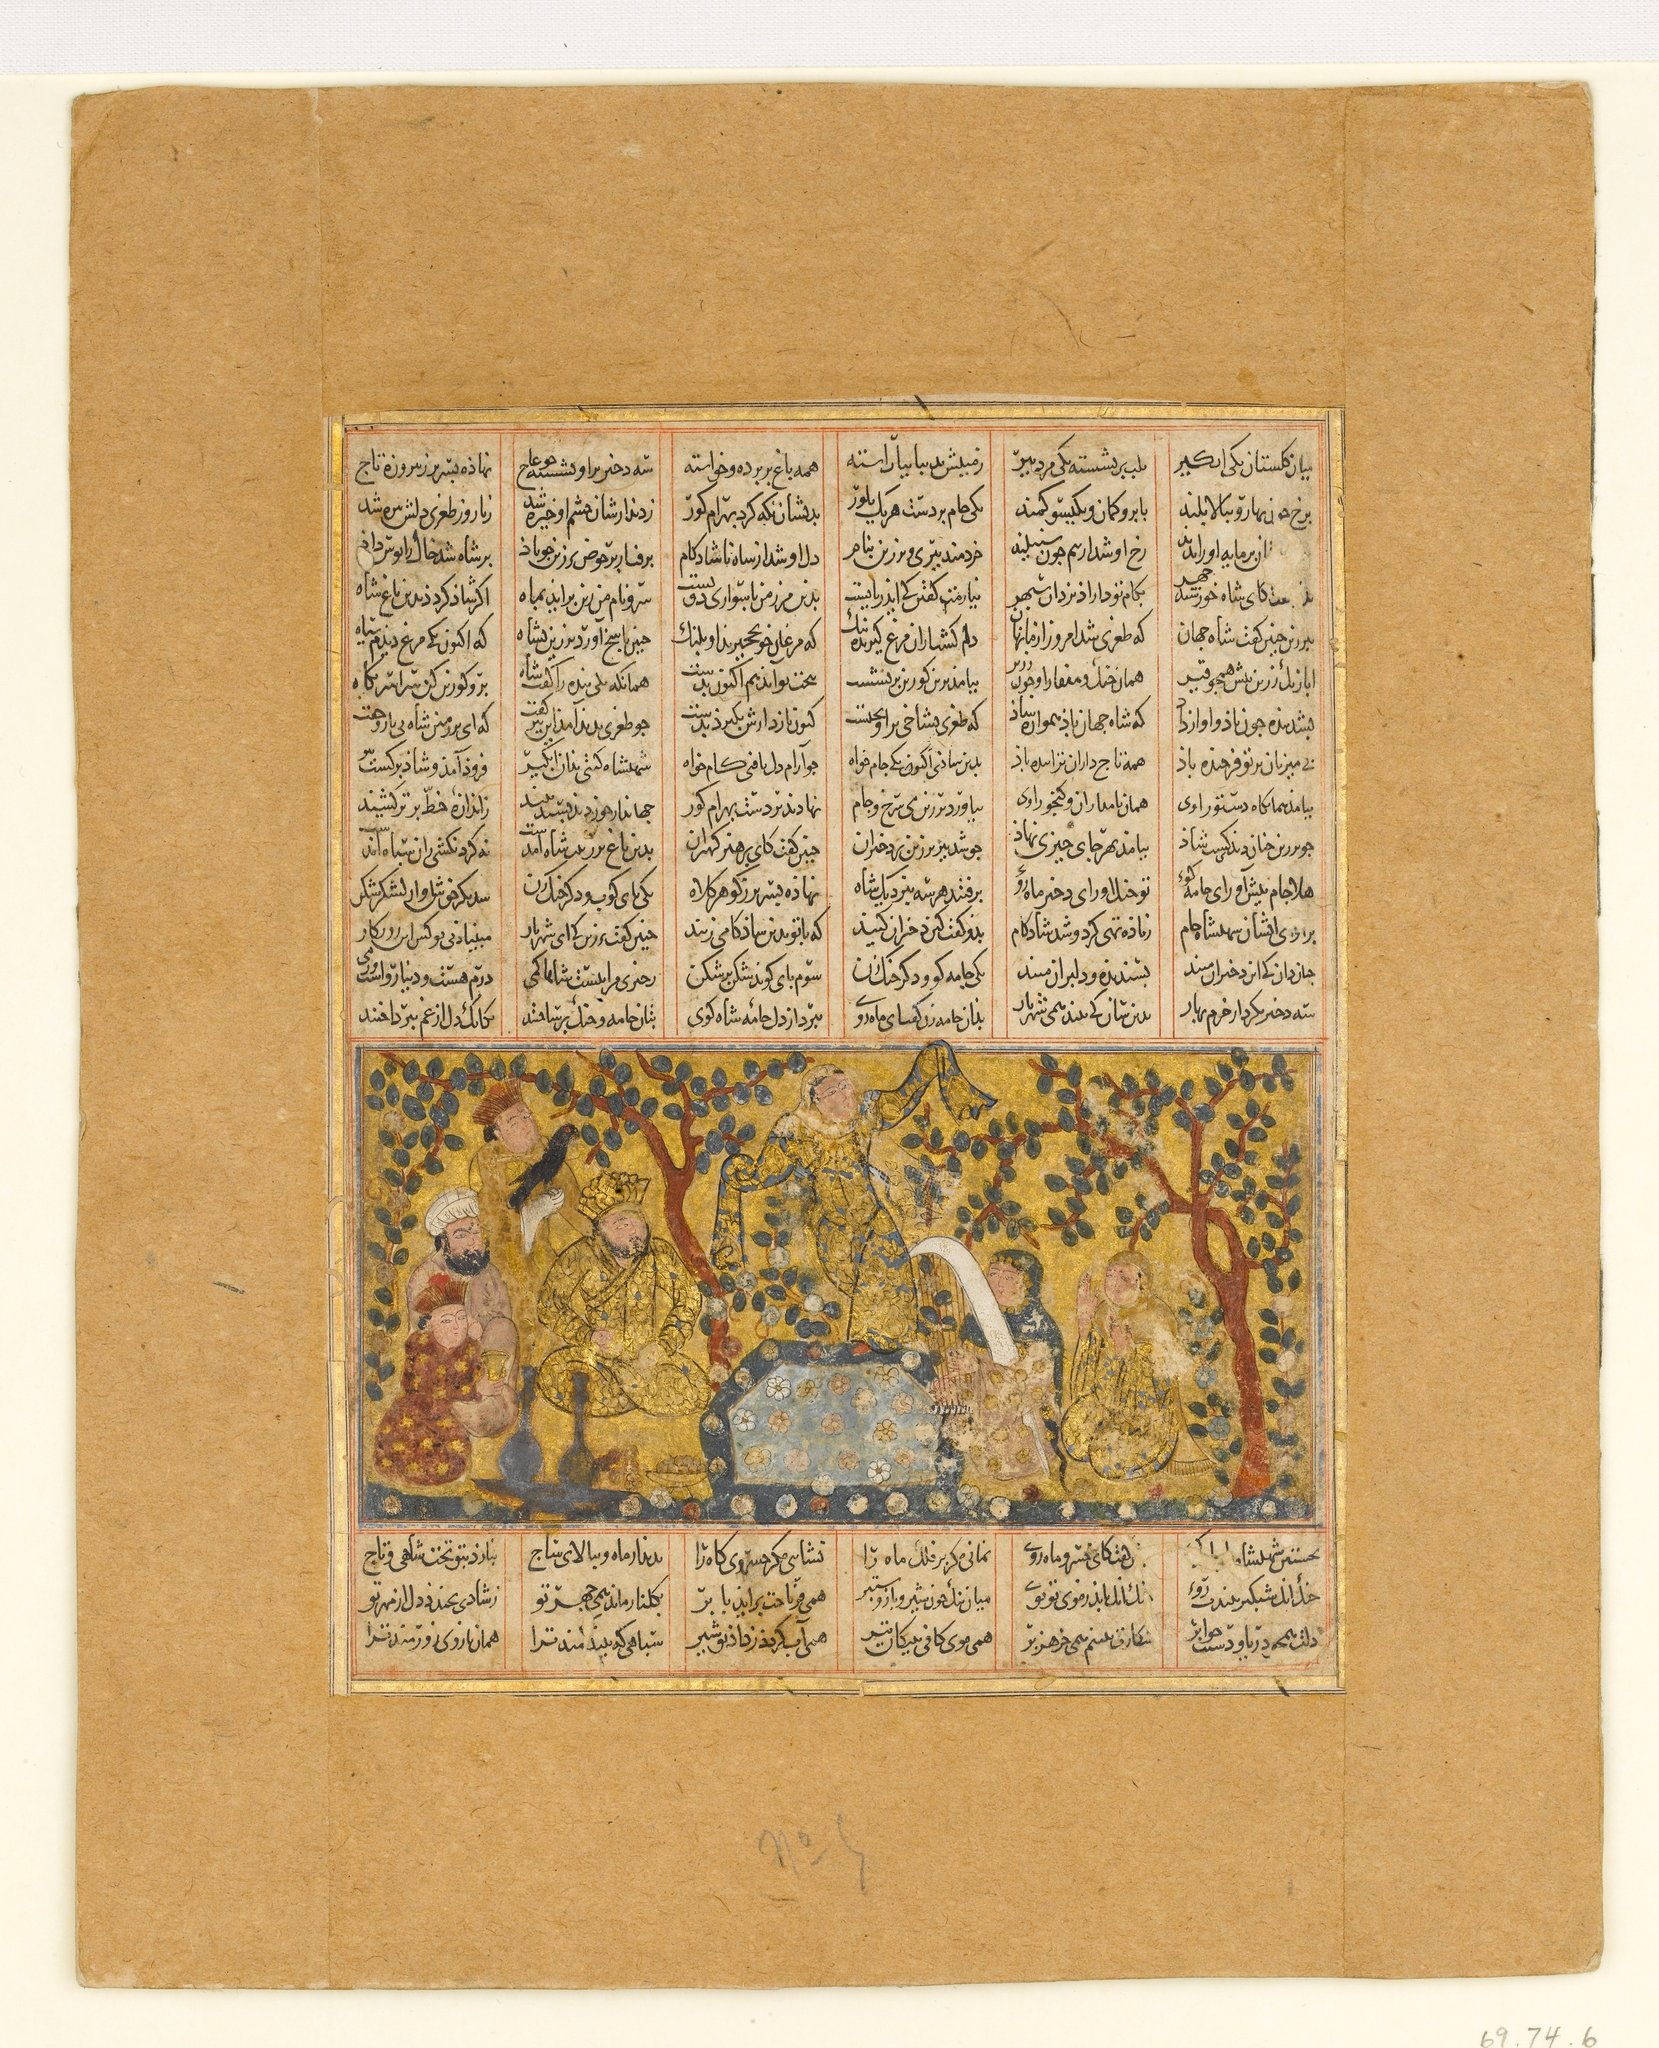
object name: folio from an illustrated manuscript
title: "Bahram Gur Entertained by the Daughters of Barzin", Folio from a Shahnama (Book of Kings)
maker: abu'l qasim firdausi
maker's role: author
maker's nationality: iranian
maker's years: 935-1020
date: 1300-1330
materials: gold, ink, paper, silver, watercolor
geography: iran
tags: falcons,men,harps